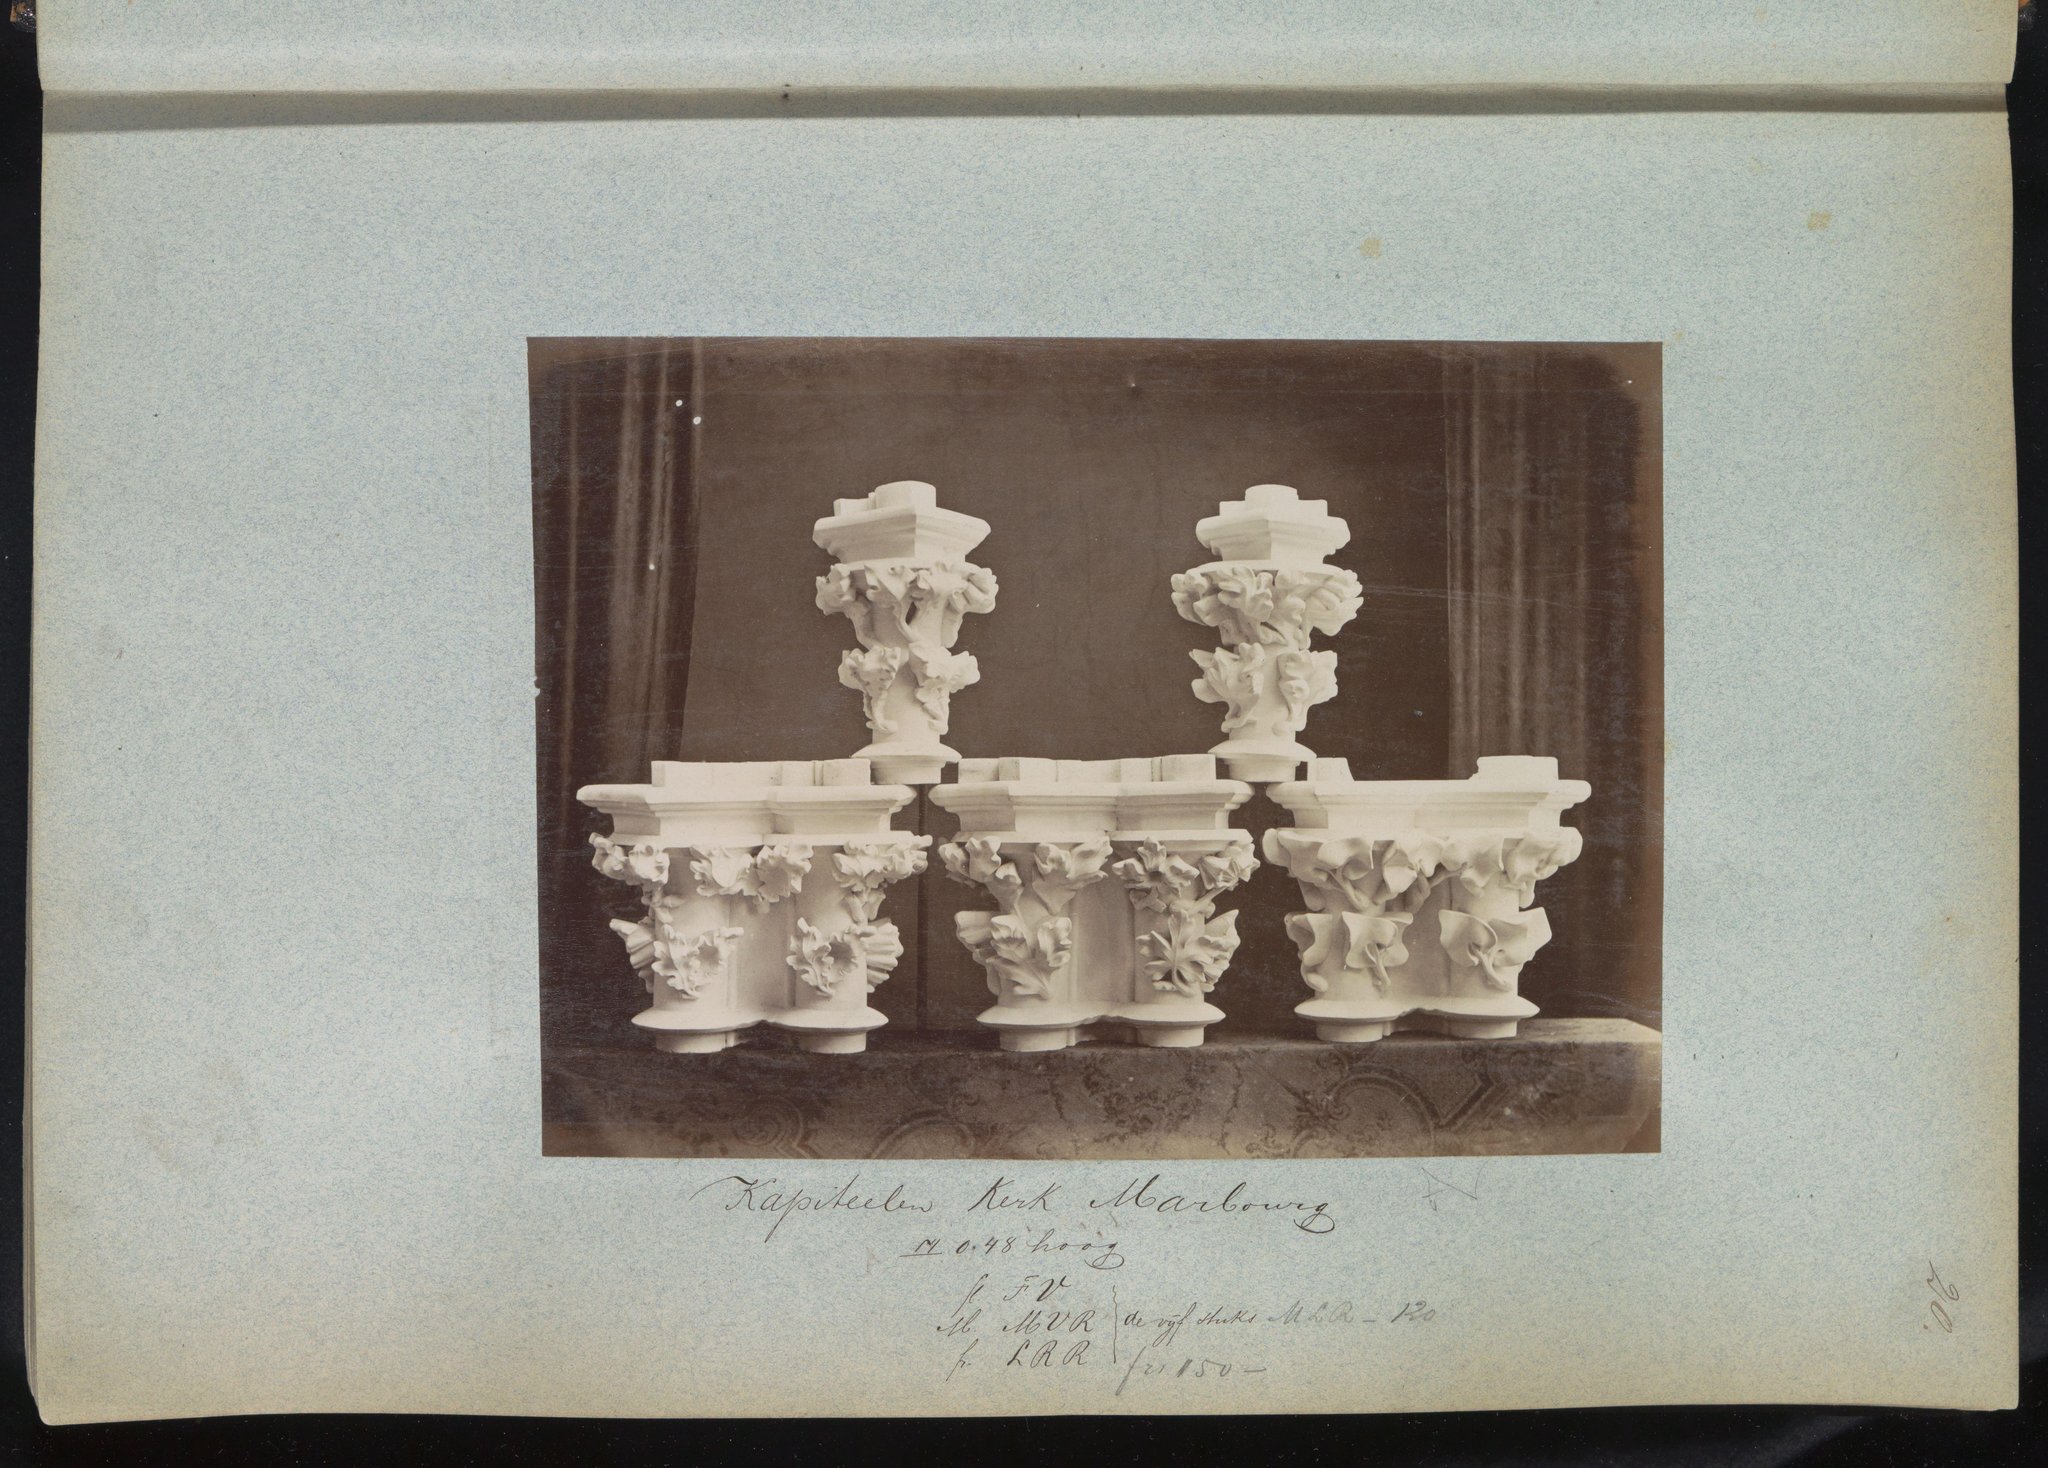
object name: album leaf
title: Vijf gipsen afgietsels van kapitelen uit een kerk te Marburg, mogelijk de Elisabethkerk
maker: Anonymous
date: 1875-1900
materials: paper, photographic support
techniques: albumen print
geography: marburg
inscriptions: annotation, annotation: ‘Kapiteelen Kerk Marbourg’